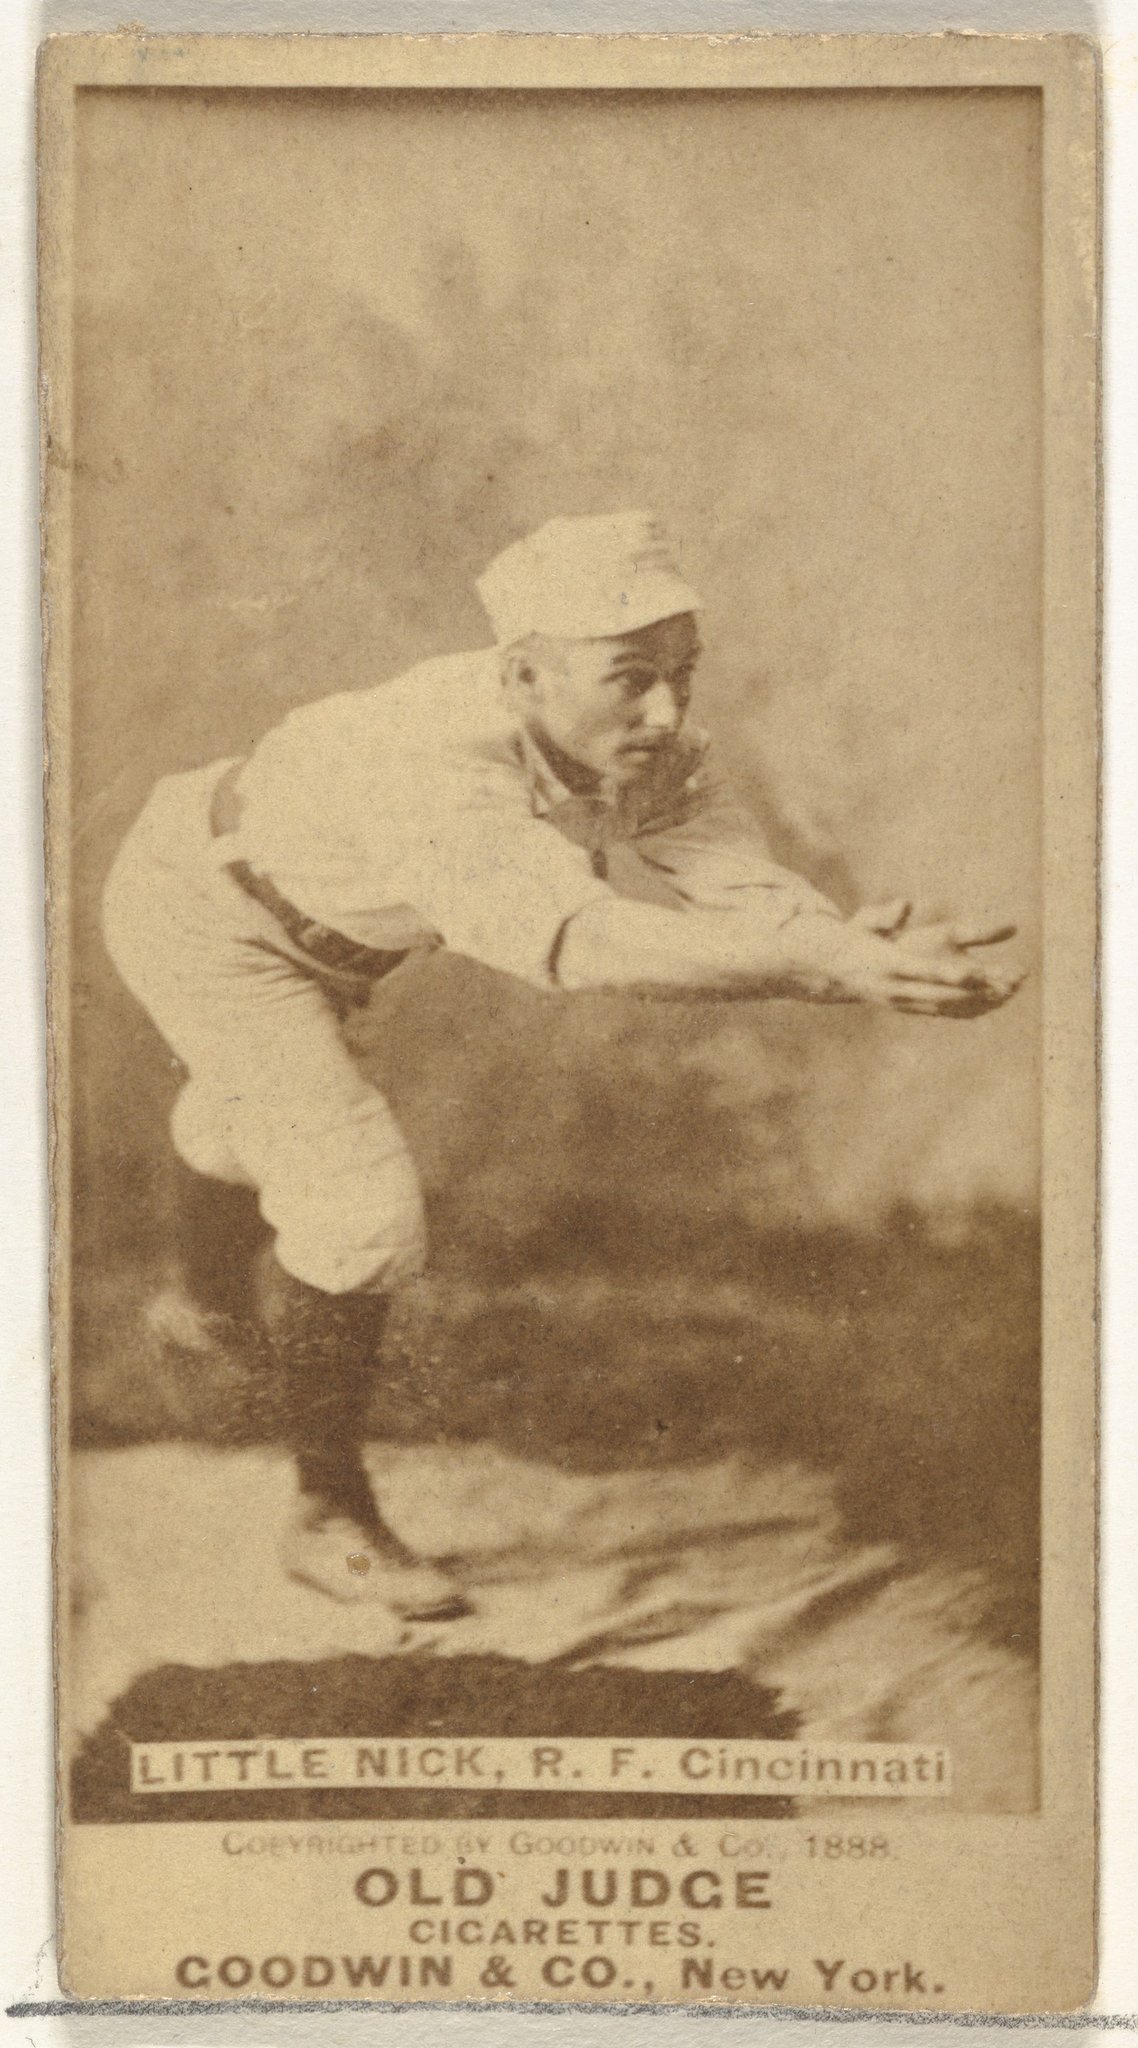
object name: baseball card, photograph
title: Hugh N. "Little Nick" Nicol, Right Field, Cincinnati, from the Old Judge series (N172) for Old Judge Cigarettes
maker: goodwin & company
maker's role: publisher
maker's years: 1850-1950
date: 1888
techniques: albumen silver print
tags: men,portraits,baseball,athletes